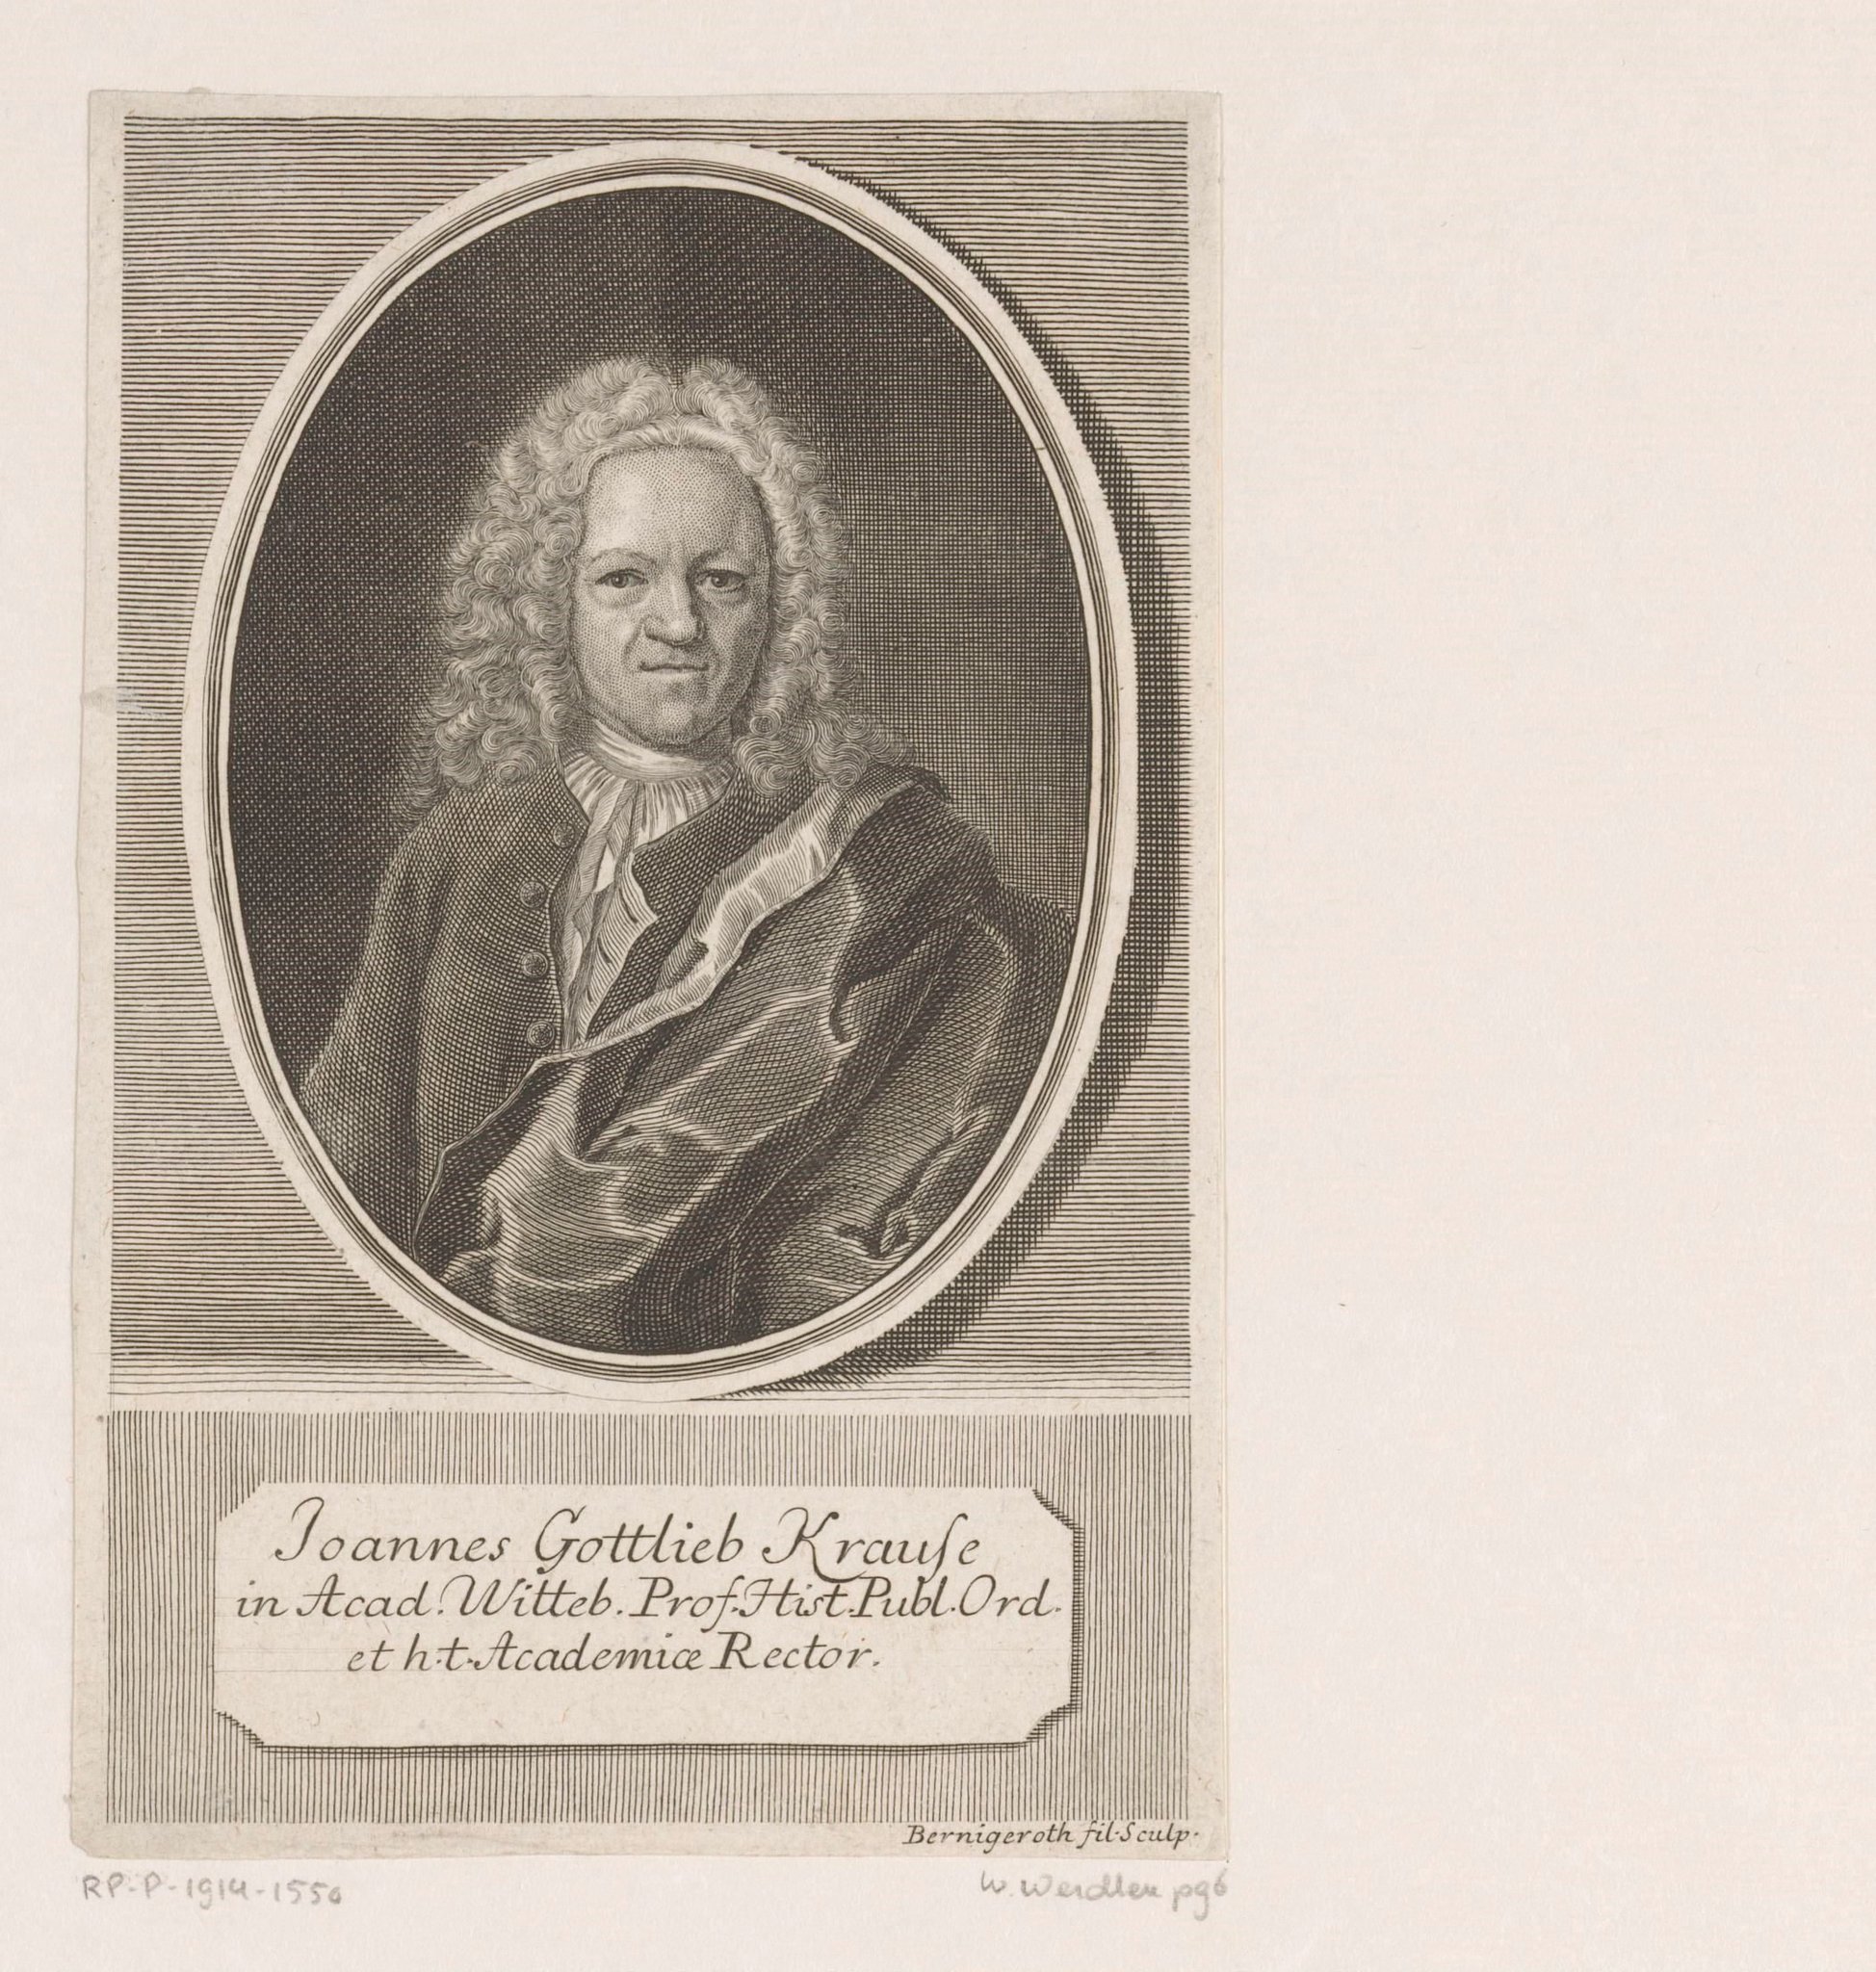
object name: print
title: Portret van Johann Gottlieb Krause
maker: johann martin bernigeroth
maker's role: print maker, publisher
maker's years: 1713-1767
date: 1734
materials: paper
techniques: engraving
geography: leipzig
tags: historical persons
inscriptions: collector's mark: Lugt 2228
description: Prent ook gebruikt in: Deutsche Acta Eruditorum (...). dl. 187. Leipzig: Johann Gottlieb Gleditsch, 1734.